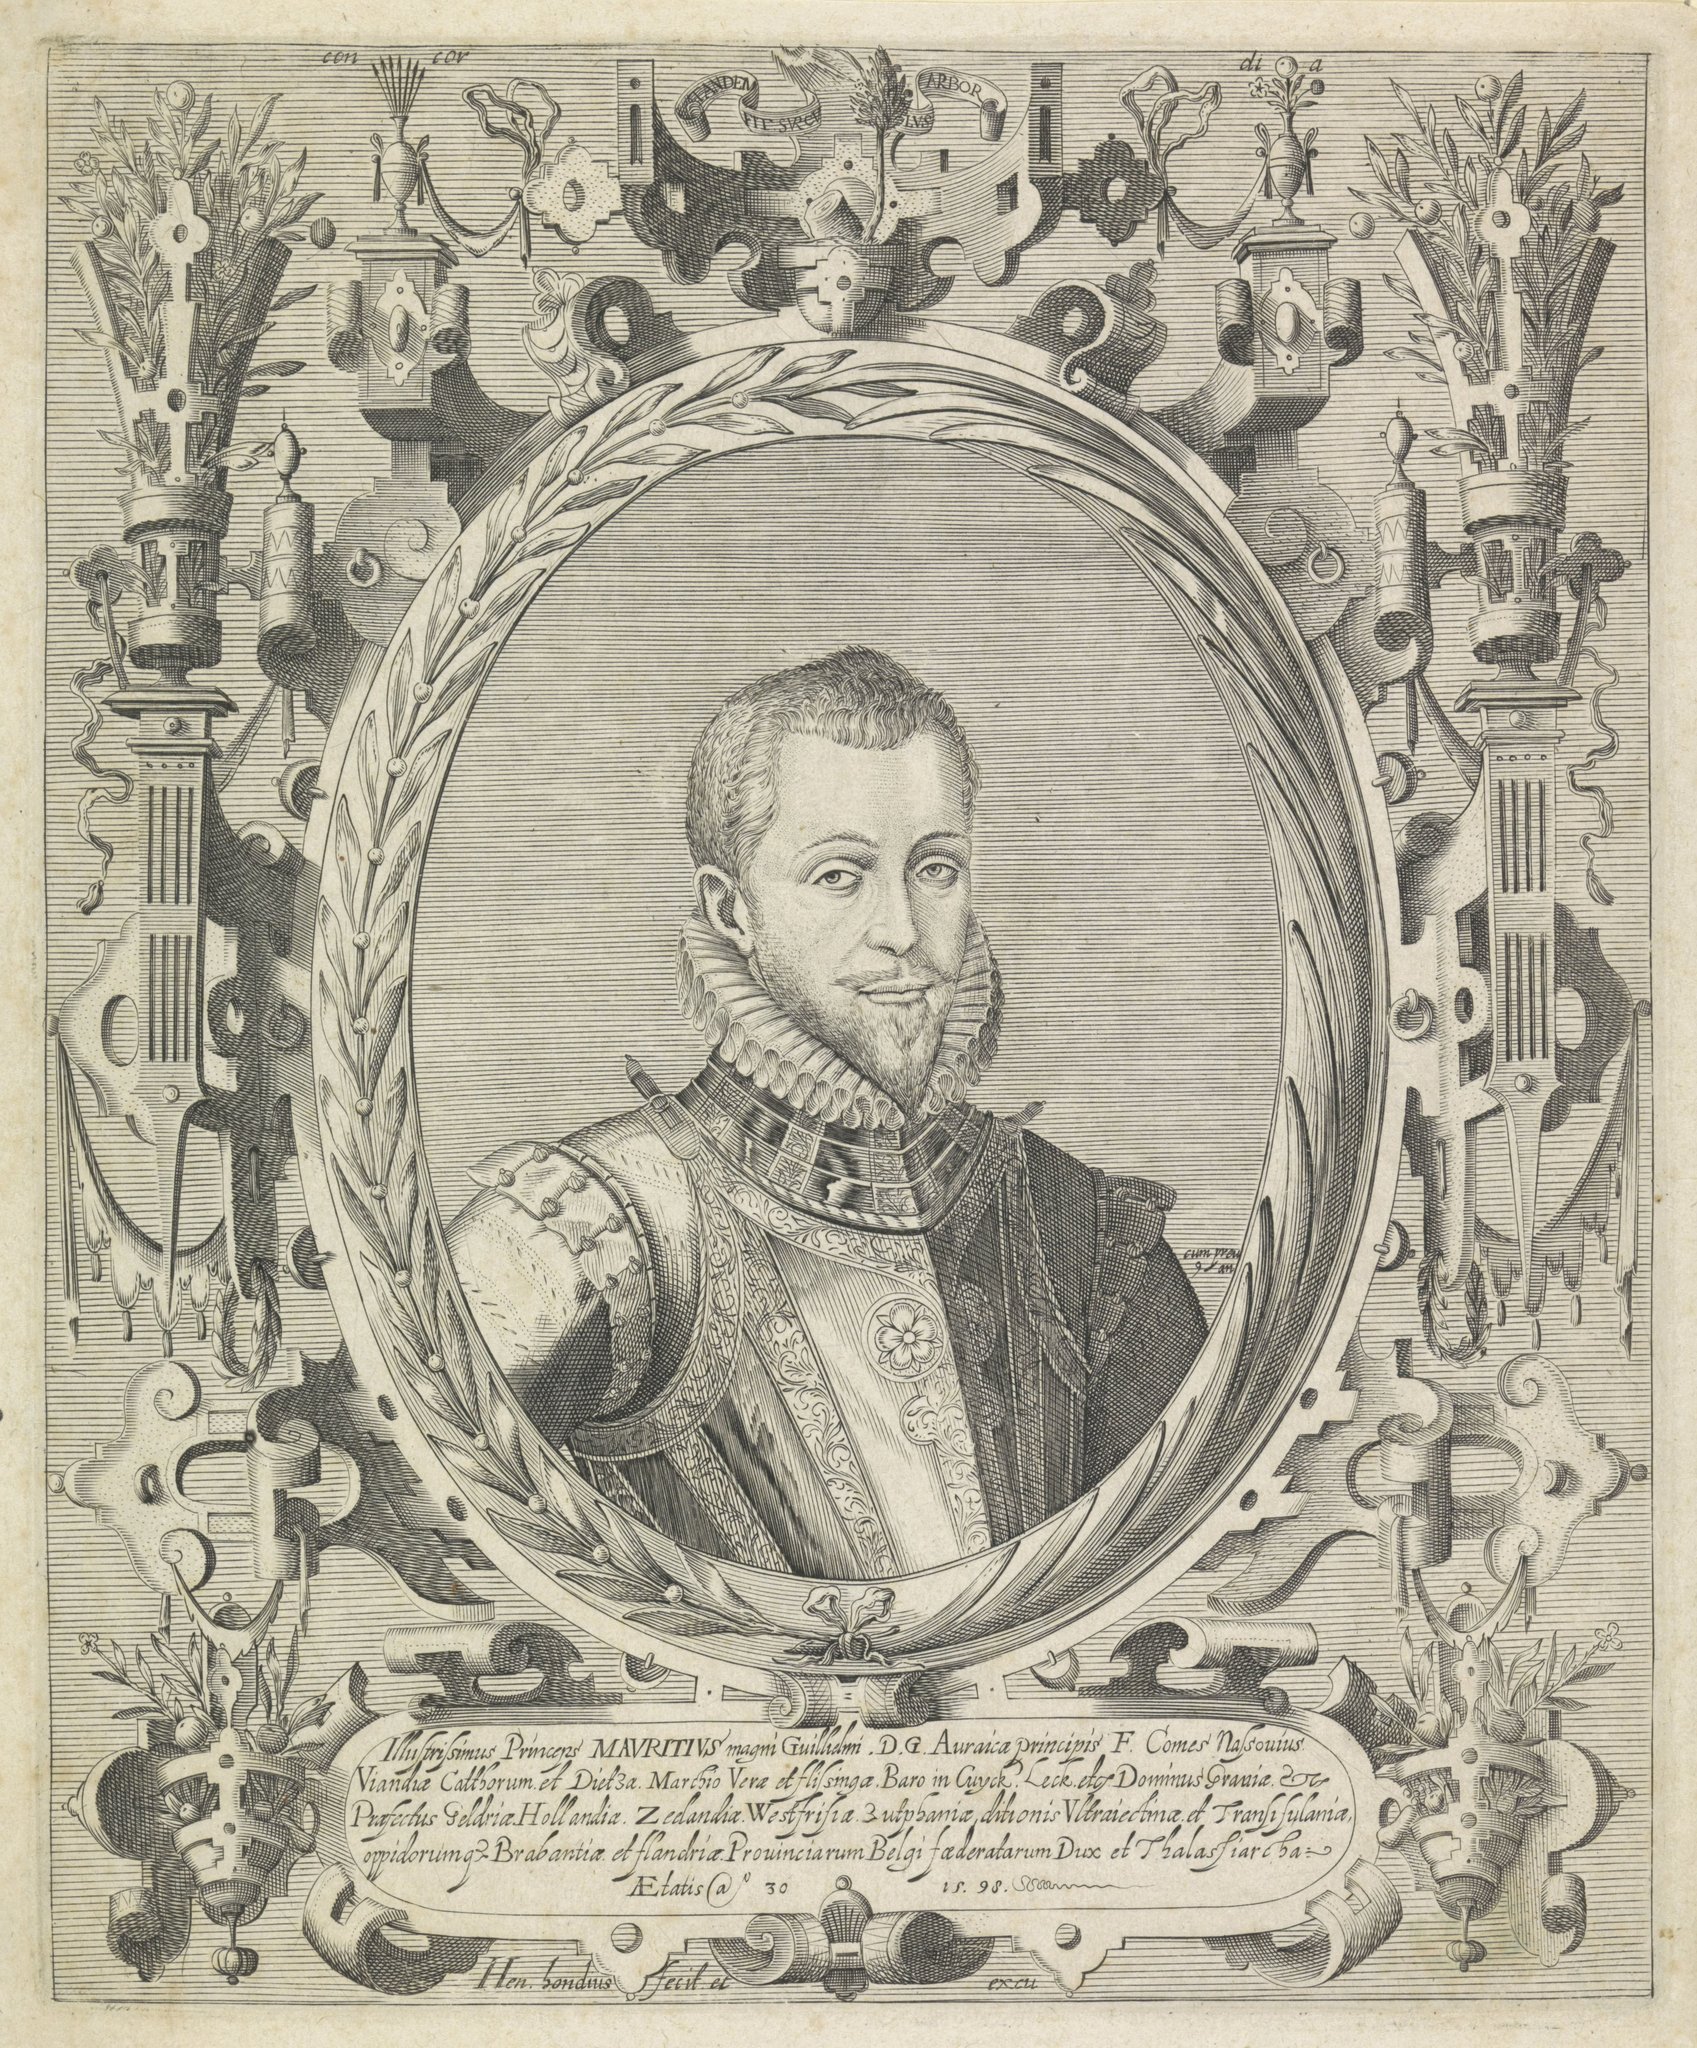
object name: print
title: Portret van Maurits, prins van Oranje, op 30-jarige leeftijd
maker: hendrick hondius (i)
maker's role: draughtsman, print maker, publisher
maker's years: 1573-1650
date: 1598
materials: paper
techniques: engraving, etching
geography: the hague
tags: maurice (prince of orange)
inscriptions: collector's mark: Lugt 963, collector's mark: Lugt 2165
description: Portret van Maurits in een ovaal van oranje- en eikentakken. In een kader vier regels Latijnse tekst. Geheel in een omlijsting met arabesken en een aantal allegorische objecten.